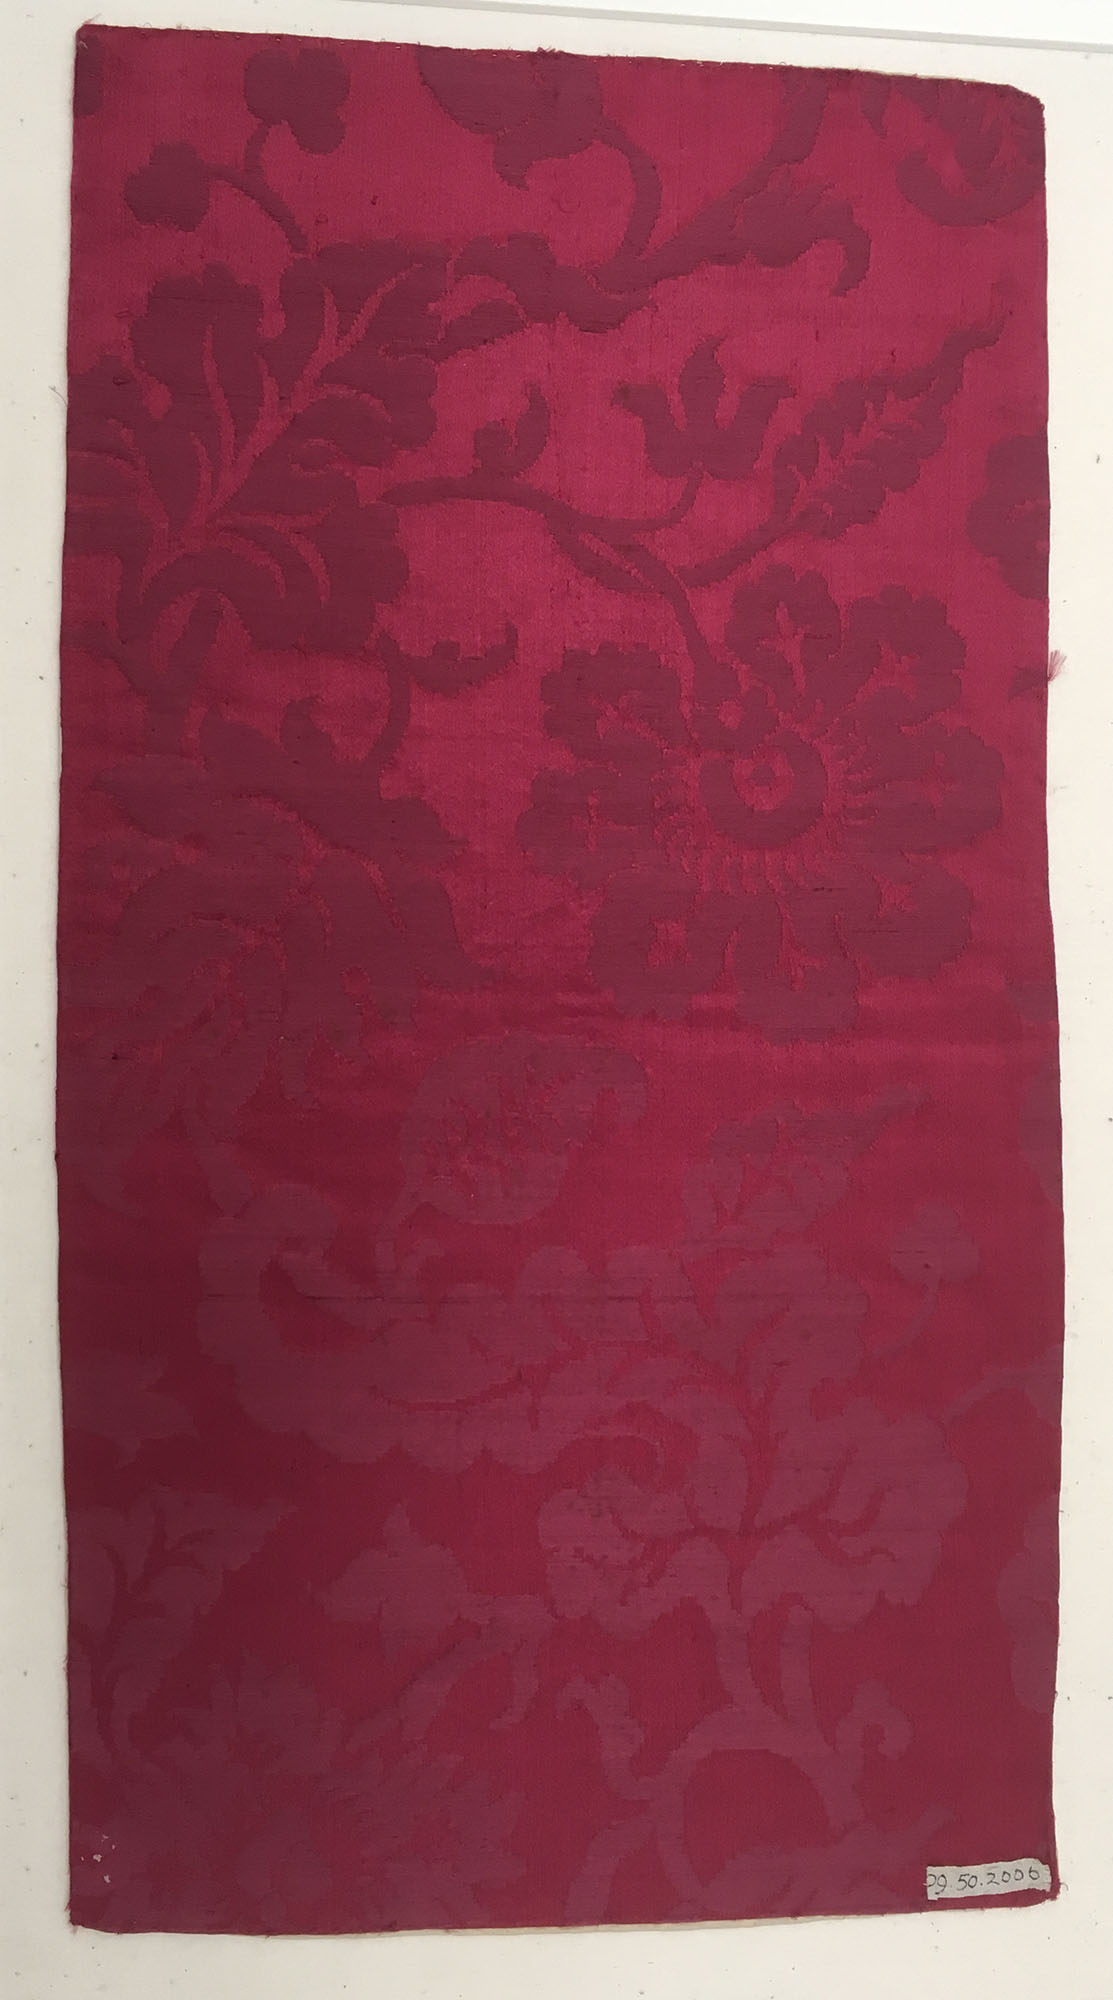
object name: piece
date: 1701-1800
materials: silk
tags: flowers,leaves